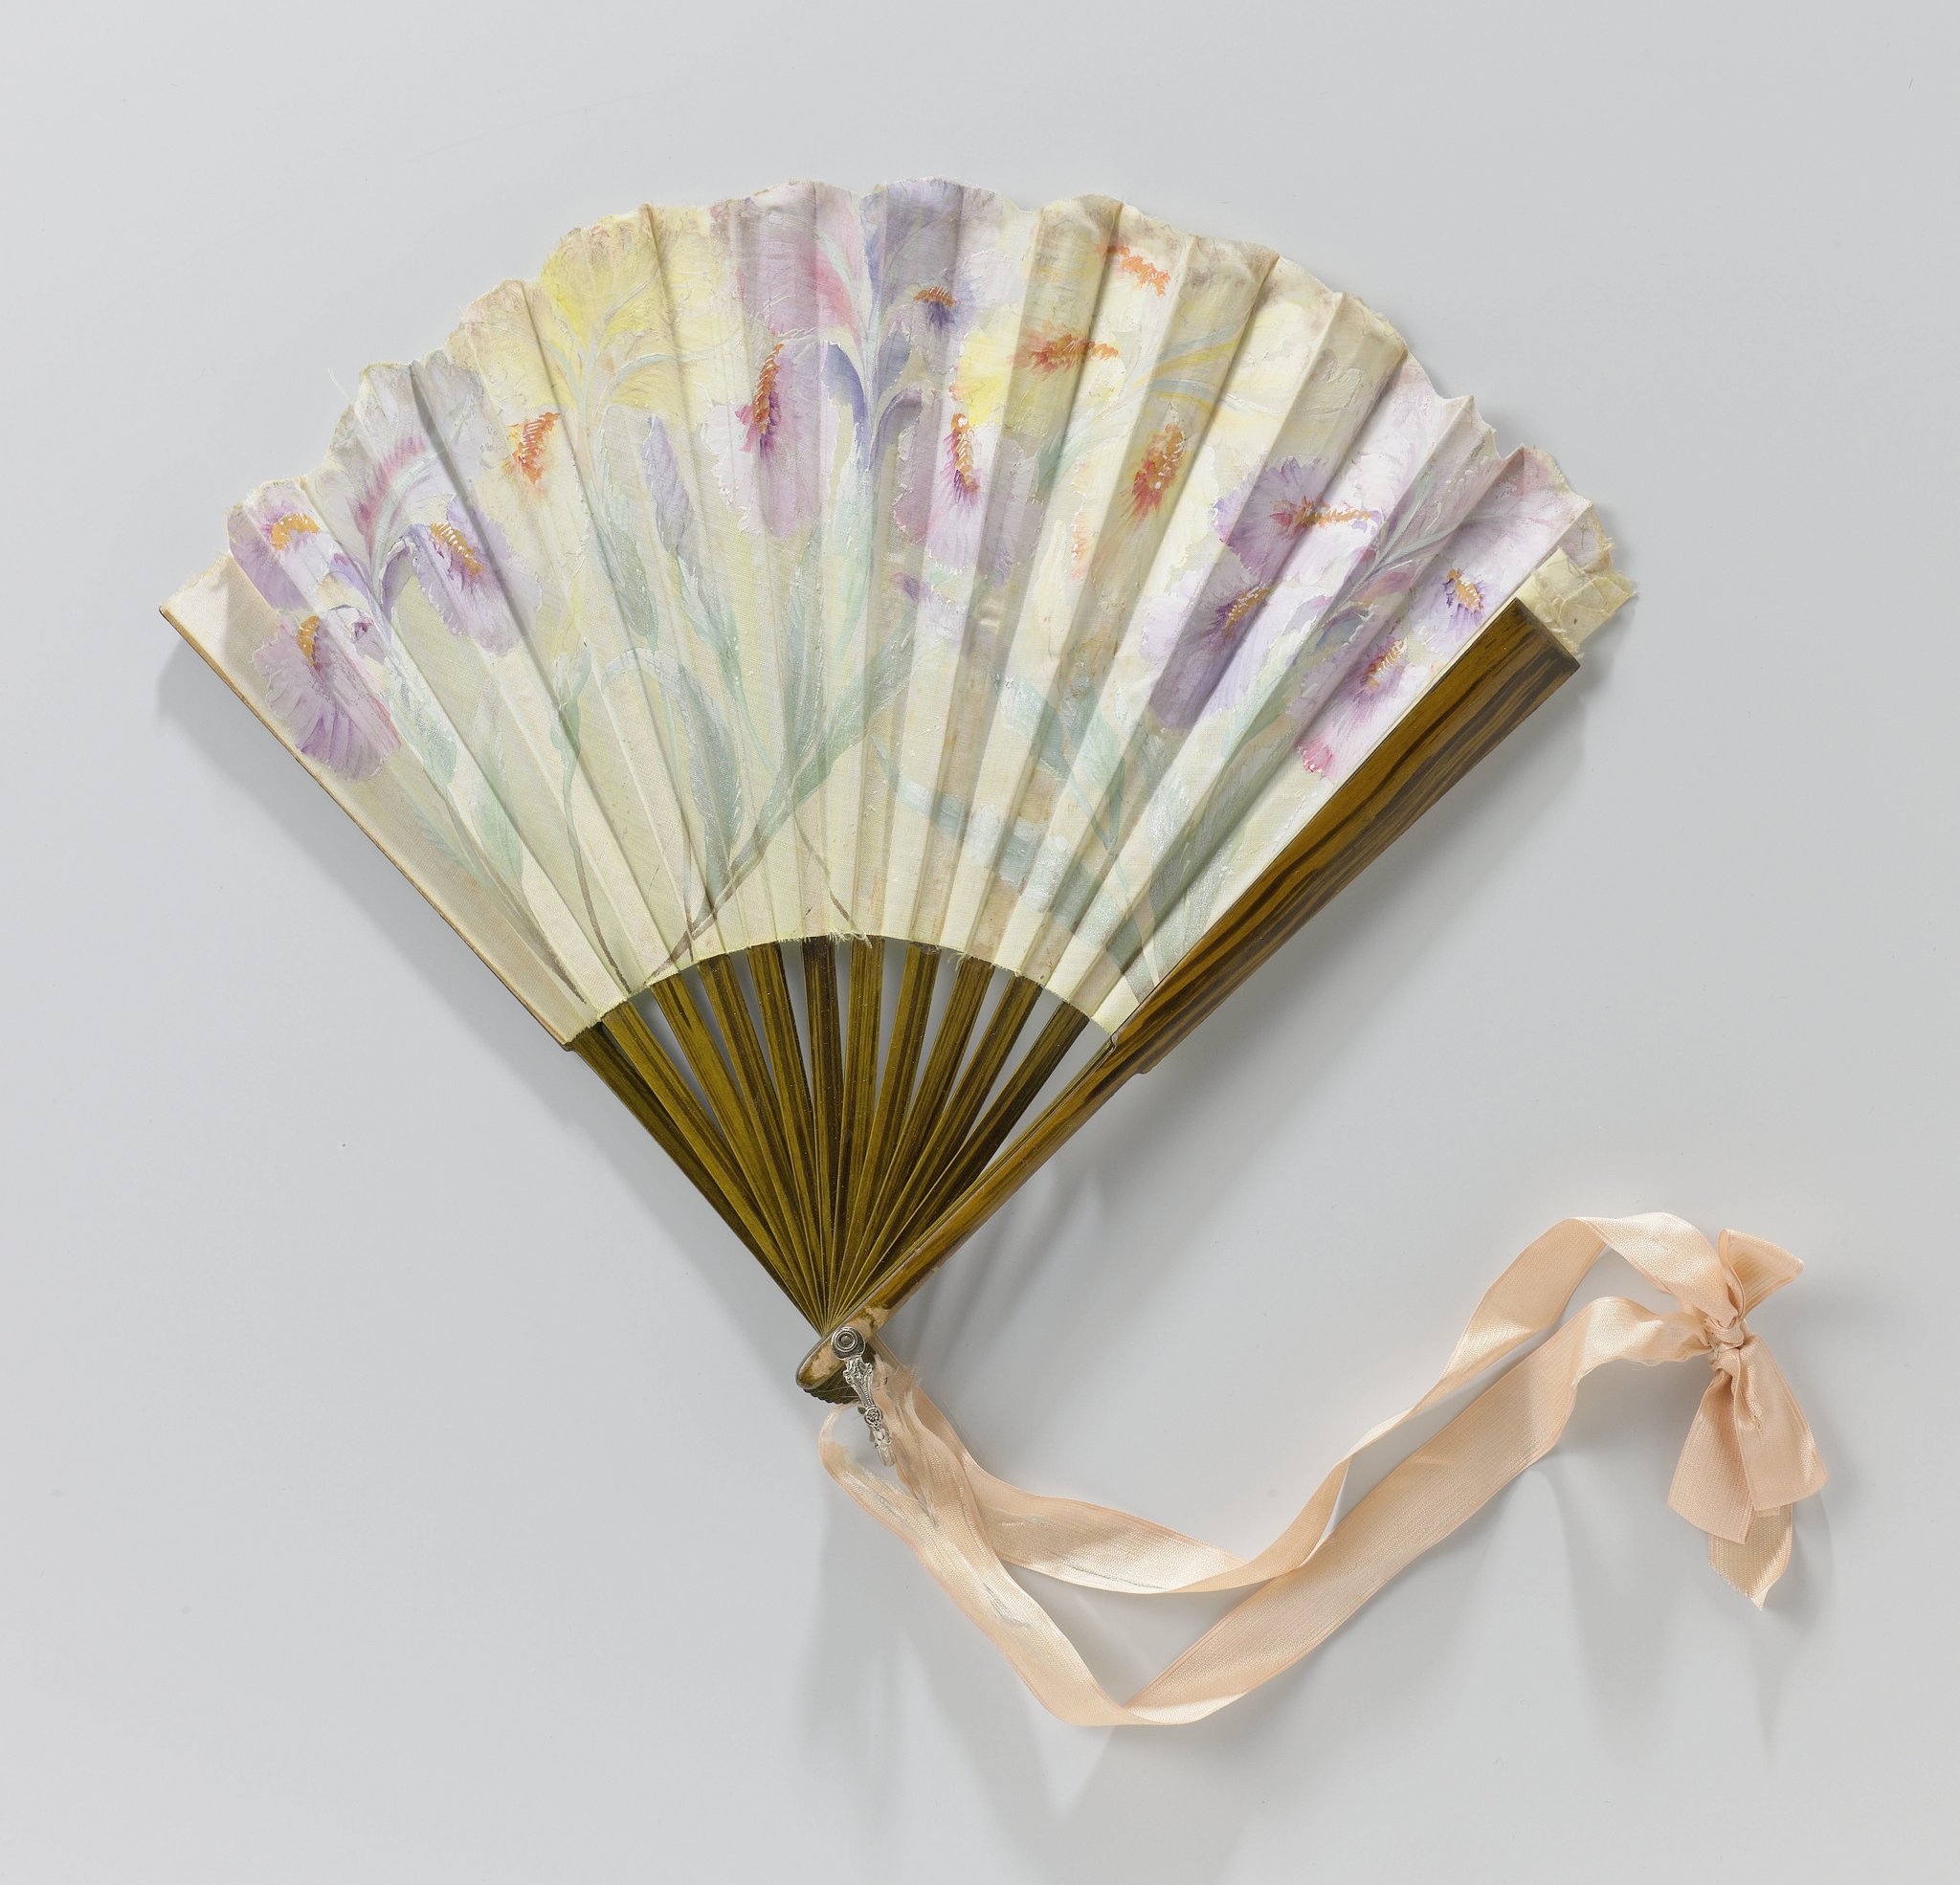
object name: vouwwaaier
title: Vouwwaaier met een cremekleurig zijden blad beschilderd met gele en lila irissen op met houtverf beschildere montuur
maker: c.d. le lorrain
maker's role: waaiermaker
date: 1911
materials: metal, oil, paint, silk, watercolor, wood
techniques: cutting, forging, weave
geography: amsterdam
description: Vouwwaaier met een cremekleurig zijden blad met aquarel, olieverf en zilververf beschilderde gele en lila irissen. Het montuur bestaat uit 15 niet aaneengesloten benen van hout en met houtverf beschilderd. Waaierring zilverkleurig, waaraan satijn lint. Achterzijde blad niet beschilderd.